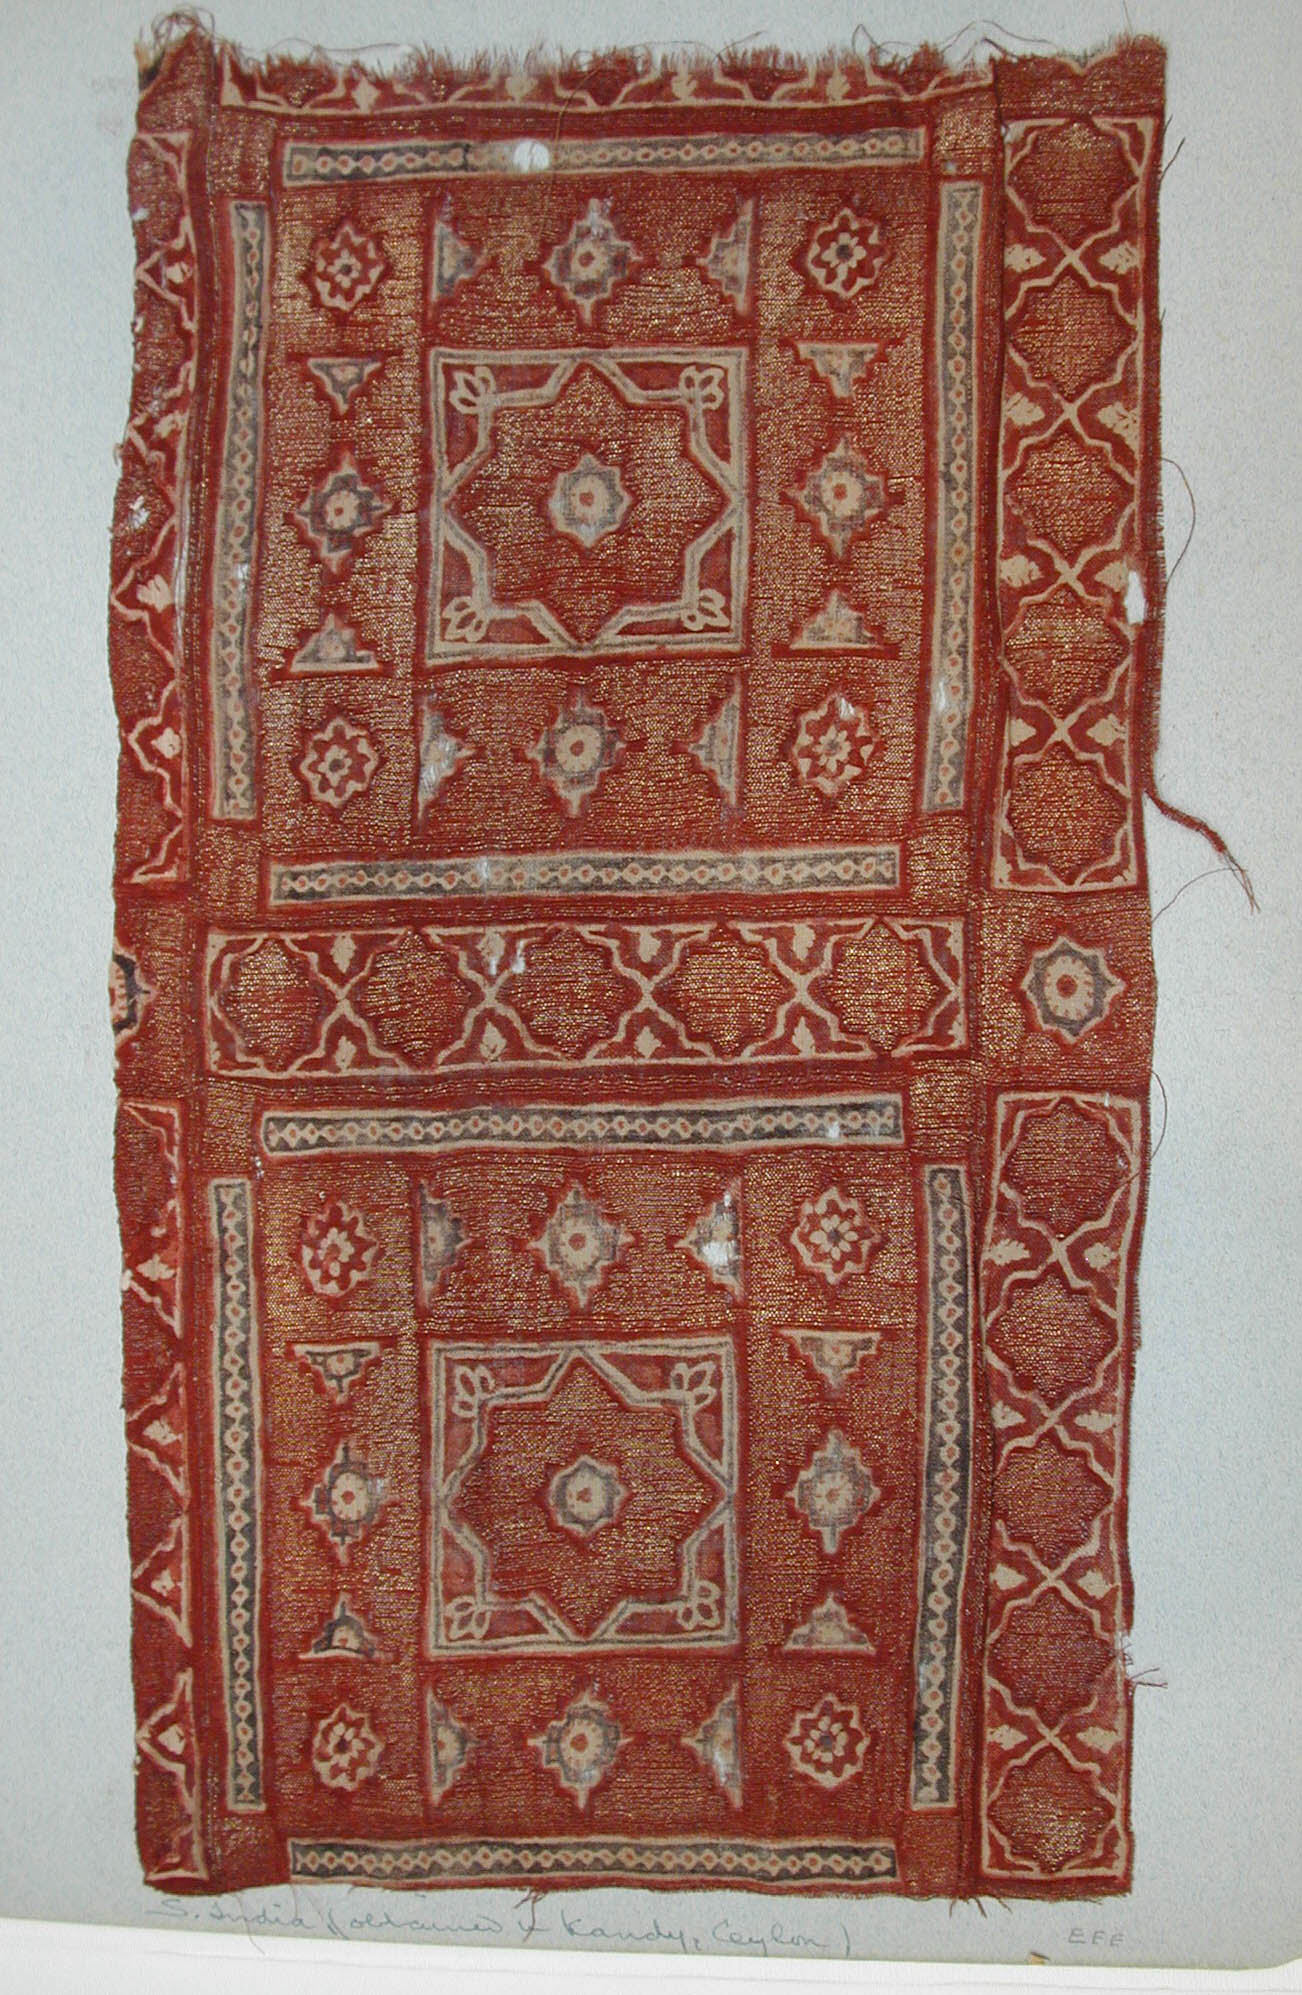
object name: sari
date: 1601-1700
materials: cotton, metal thread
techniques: brocade, printing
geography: india